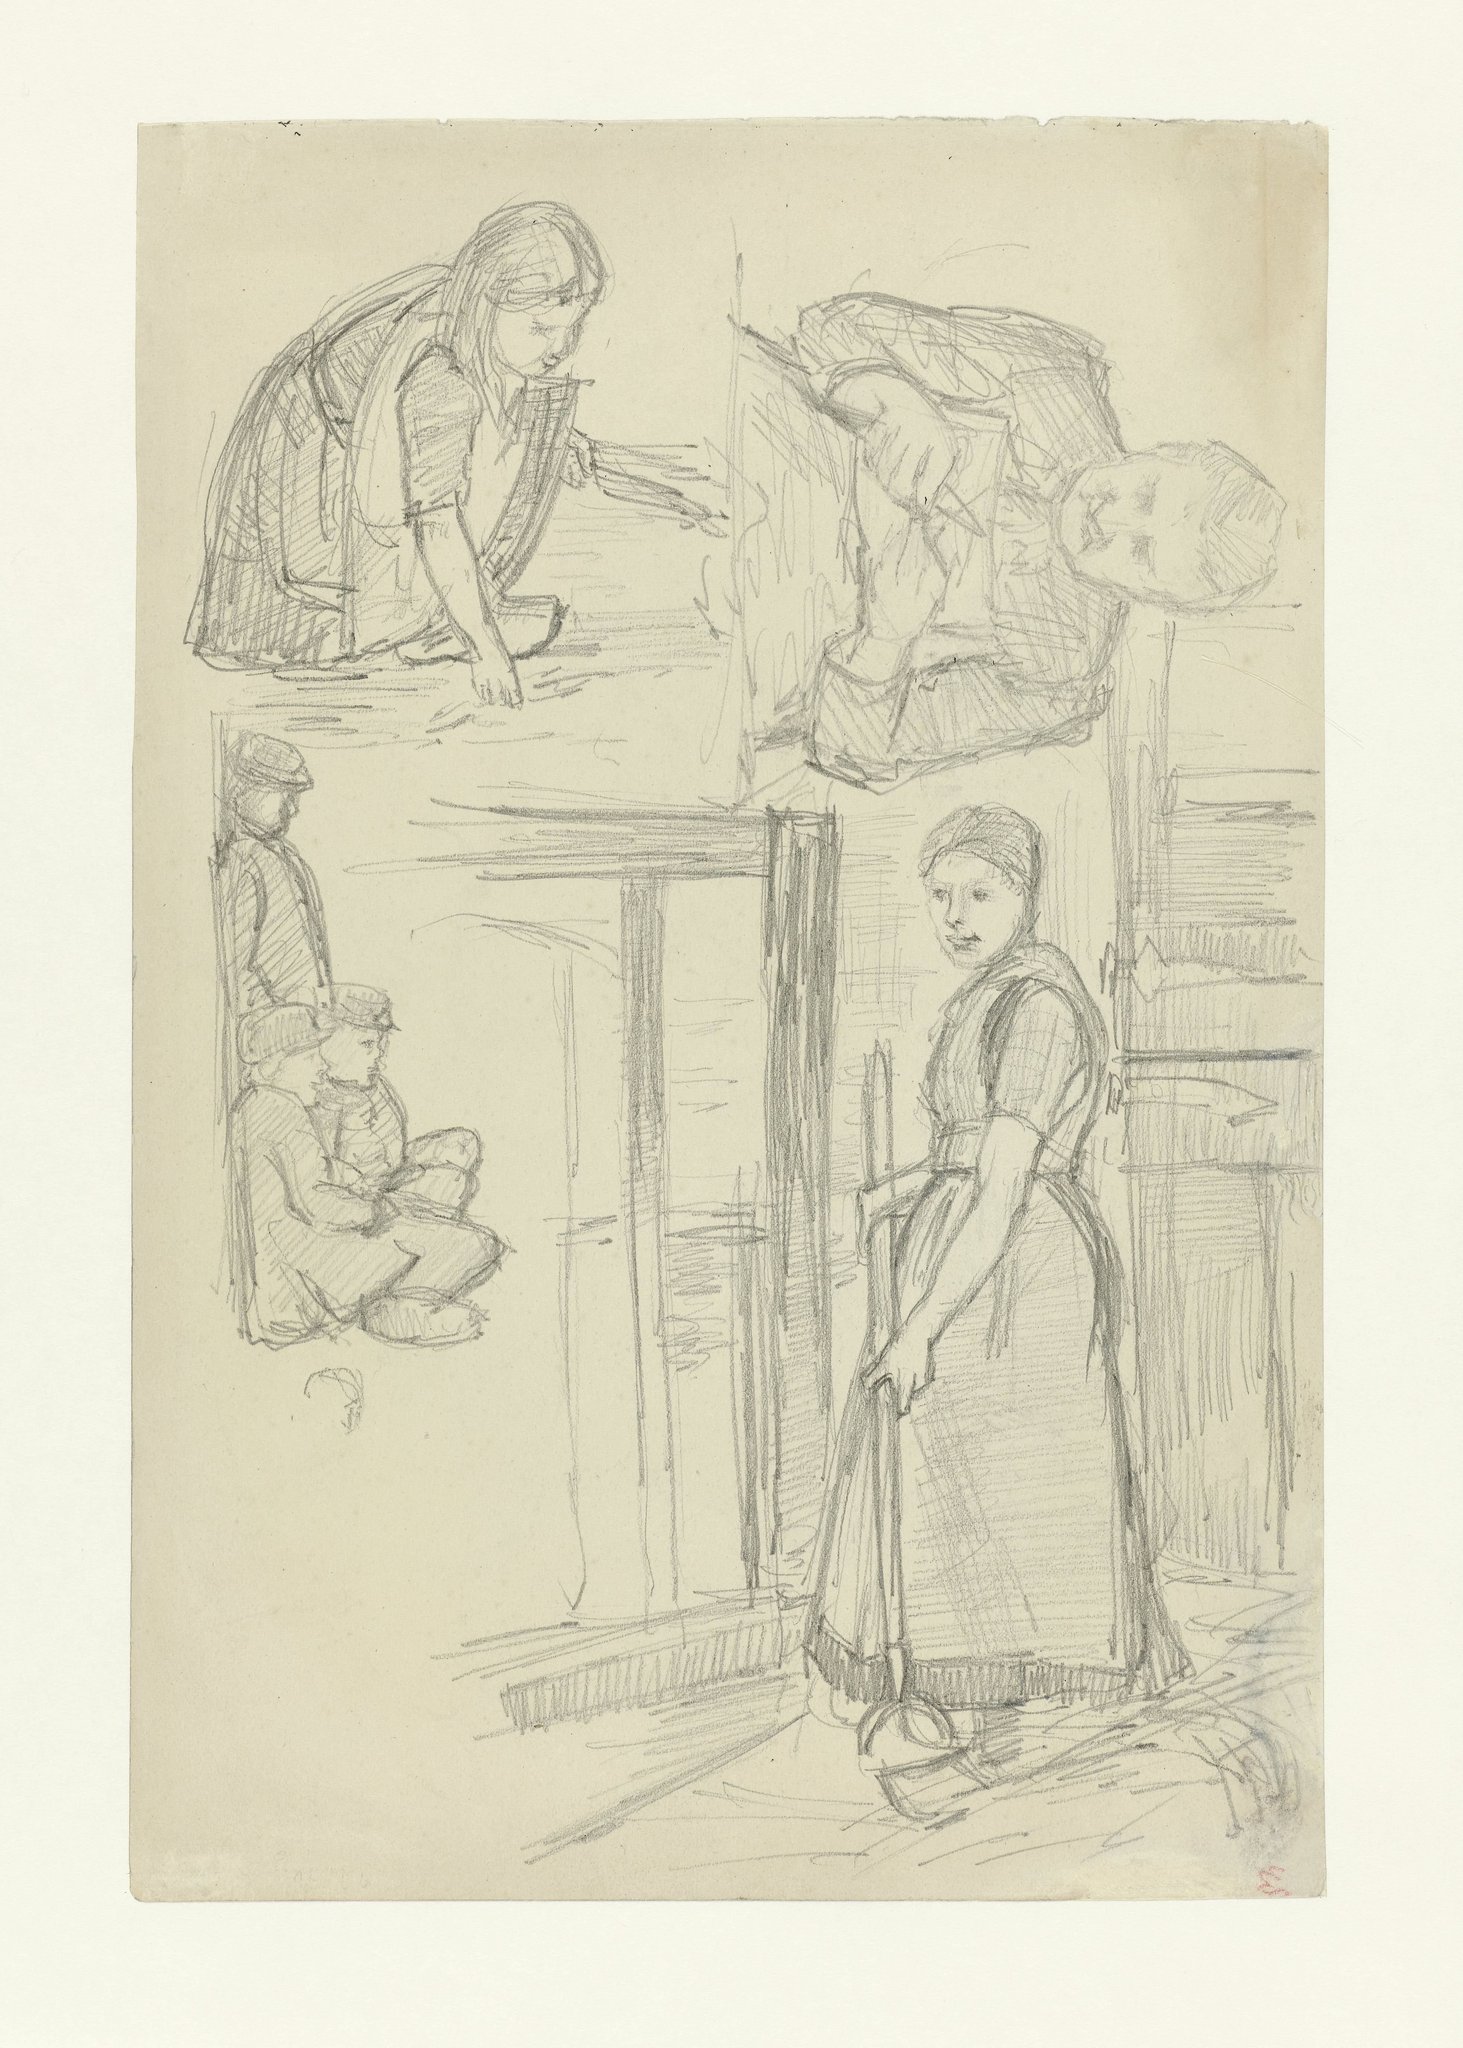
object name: drawing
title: Studieblad met vrouwen en kinderen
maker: jozef israëls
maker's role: draughtsman, painter, print maker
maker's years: 1824-1911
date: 1834-1911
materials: paper, pencil